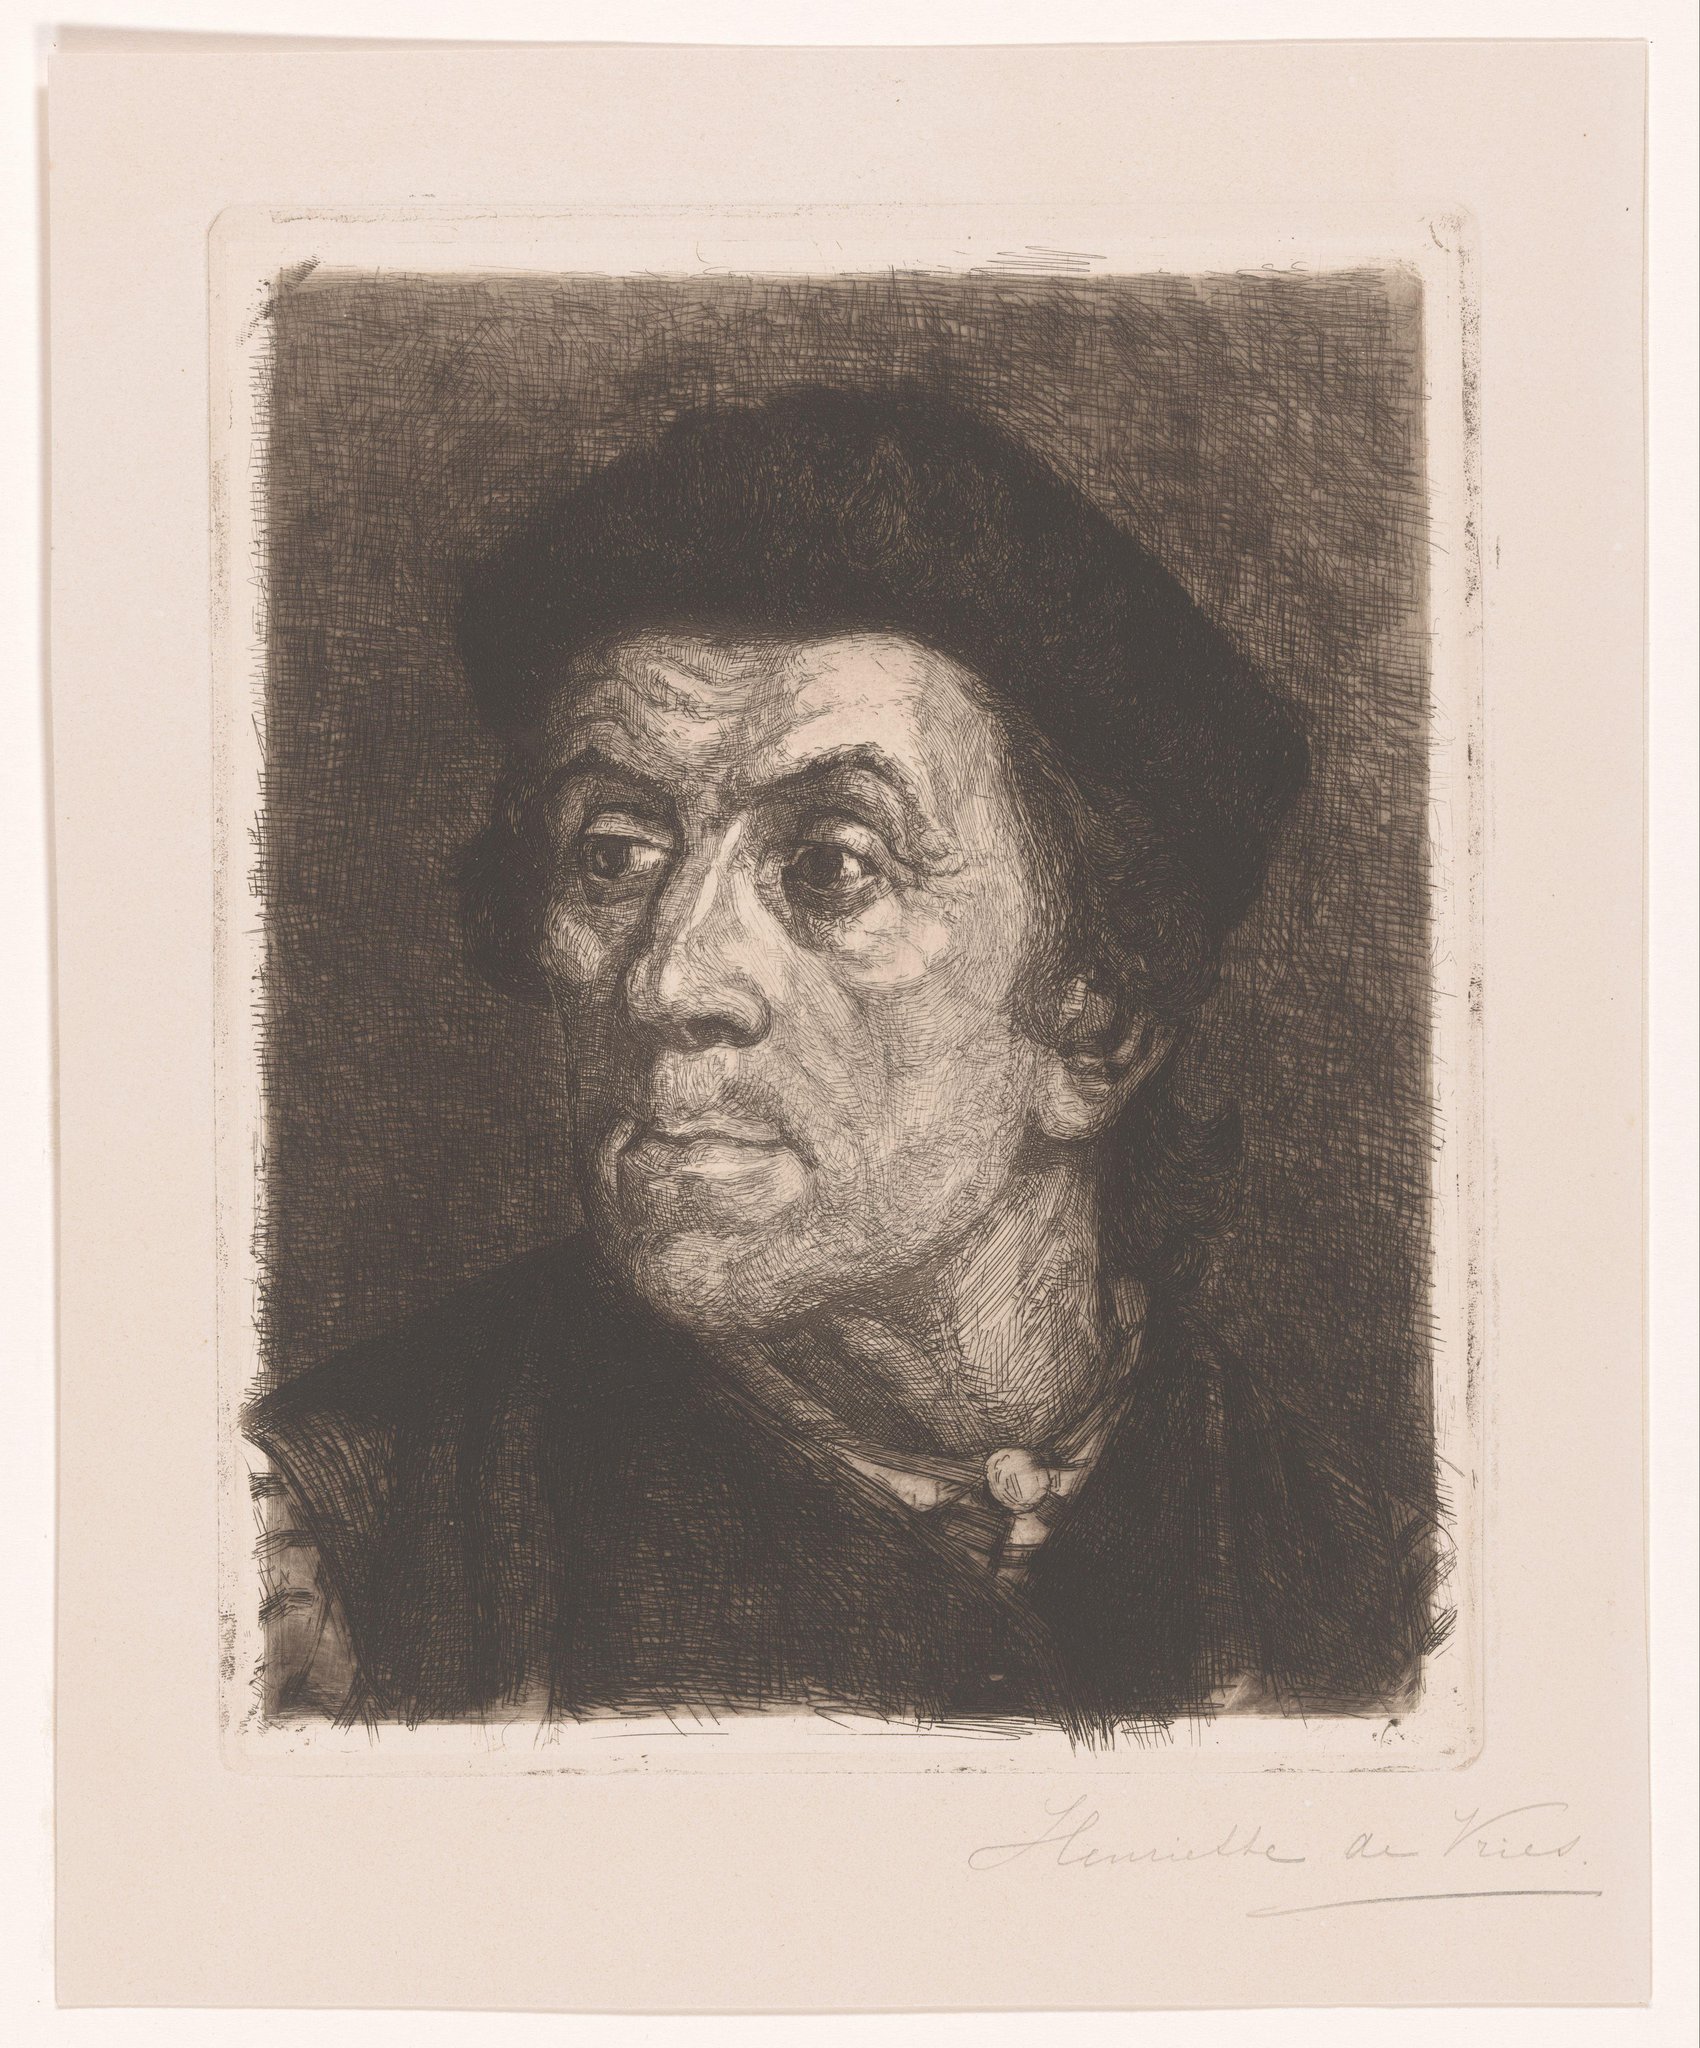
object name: print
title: Portret van een onbekende man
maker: henriëtte de vries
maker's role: draughtsman, print maker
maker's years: 1867-1942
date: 1877-1890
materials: paper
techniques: etching, intaglio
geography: netherlands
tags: head-gear: cap (+ men's clothes), historical persons not known by name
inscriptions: collector's mark: Lugt 2228